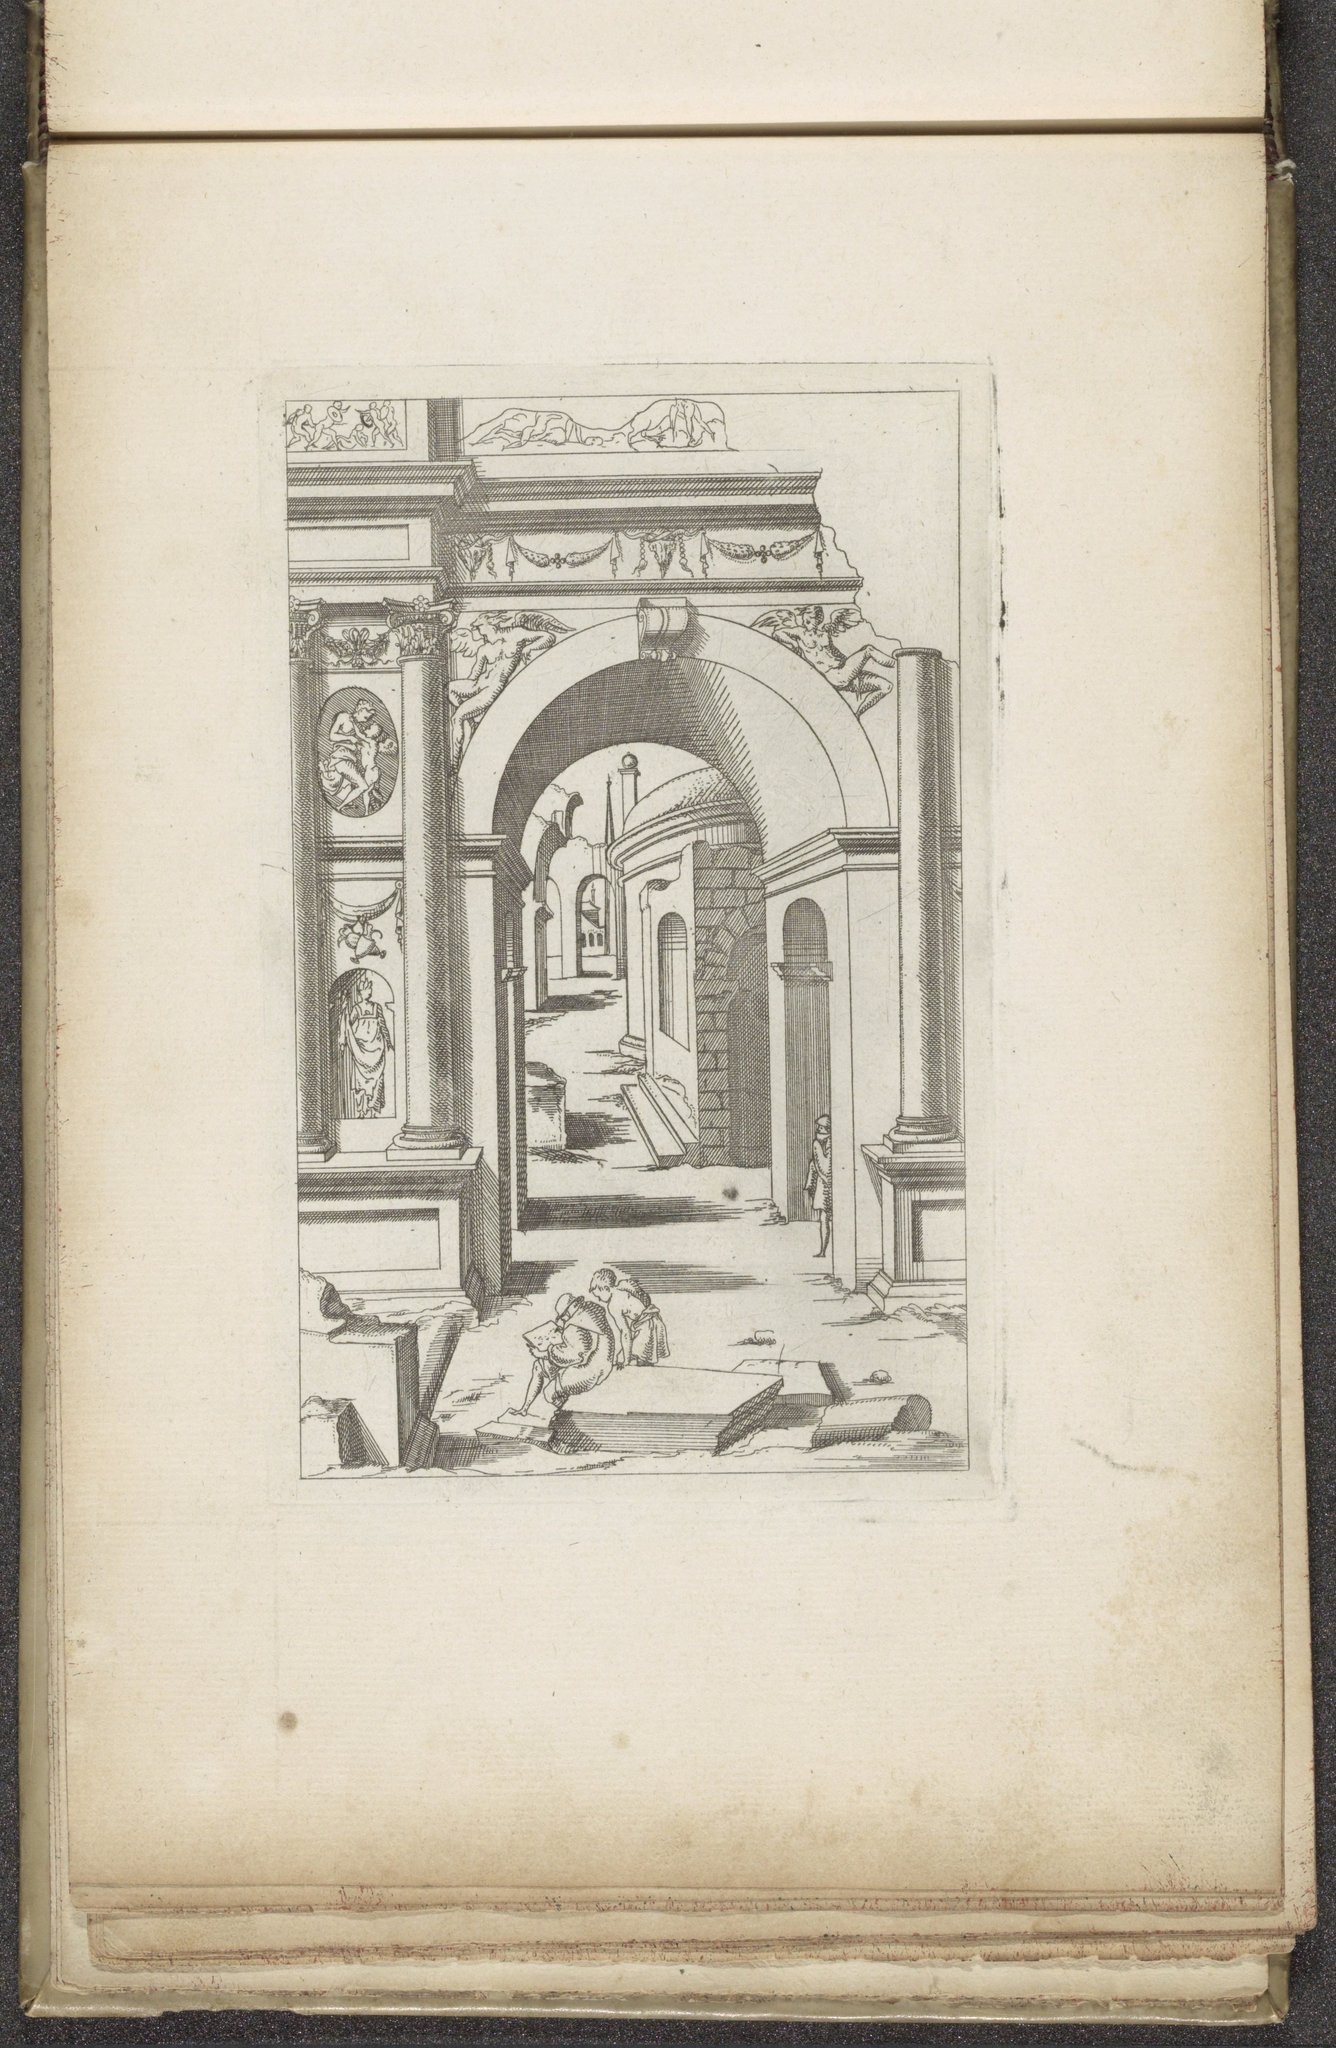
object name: print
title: Iacobus Androuetius Du Cerceau Lectoribus S Cum Nactus Essem Duodecim Fragmenta Structurae veteris (...)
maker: jacques androuet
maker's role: draughtsman, print maker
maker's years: 1515-1584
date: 1550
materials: paper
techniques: etching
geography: orléans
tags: ruin of a building ~ architecture, draughtsman studying classical remains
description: Overblijfselen van een triomfboog. Op de voorgrond zit een man te tekenen, terwijl een kind over zijn schouder meekijkt. Deze prent maakt deel uit van een album.